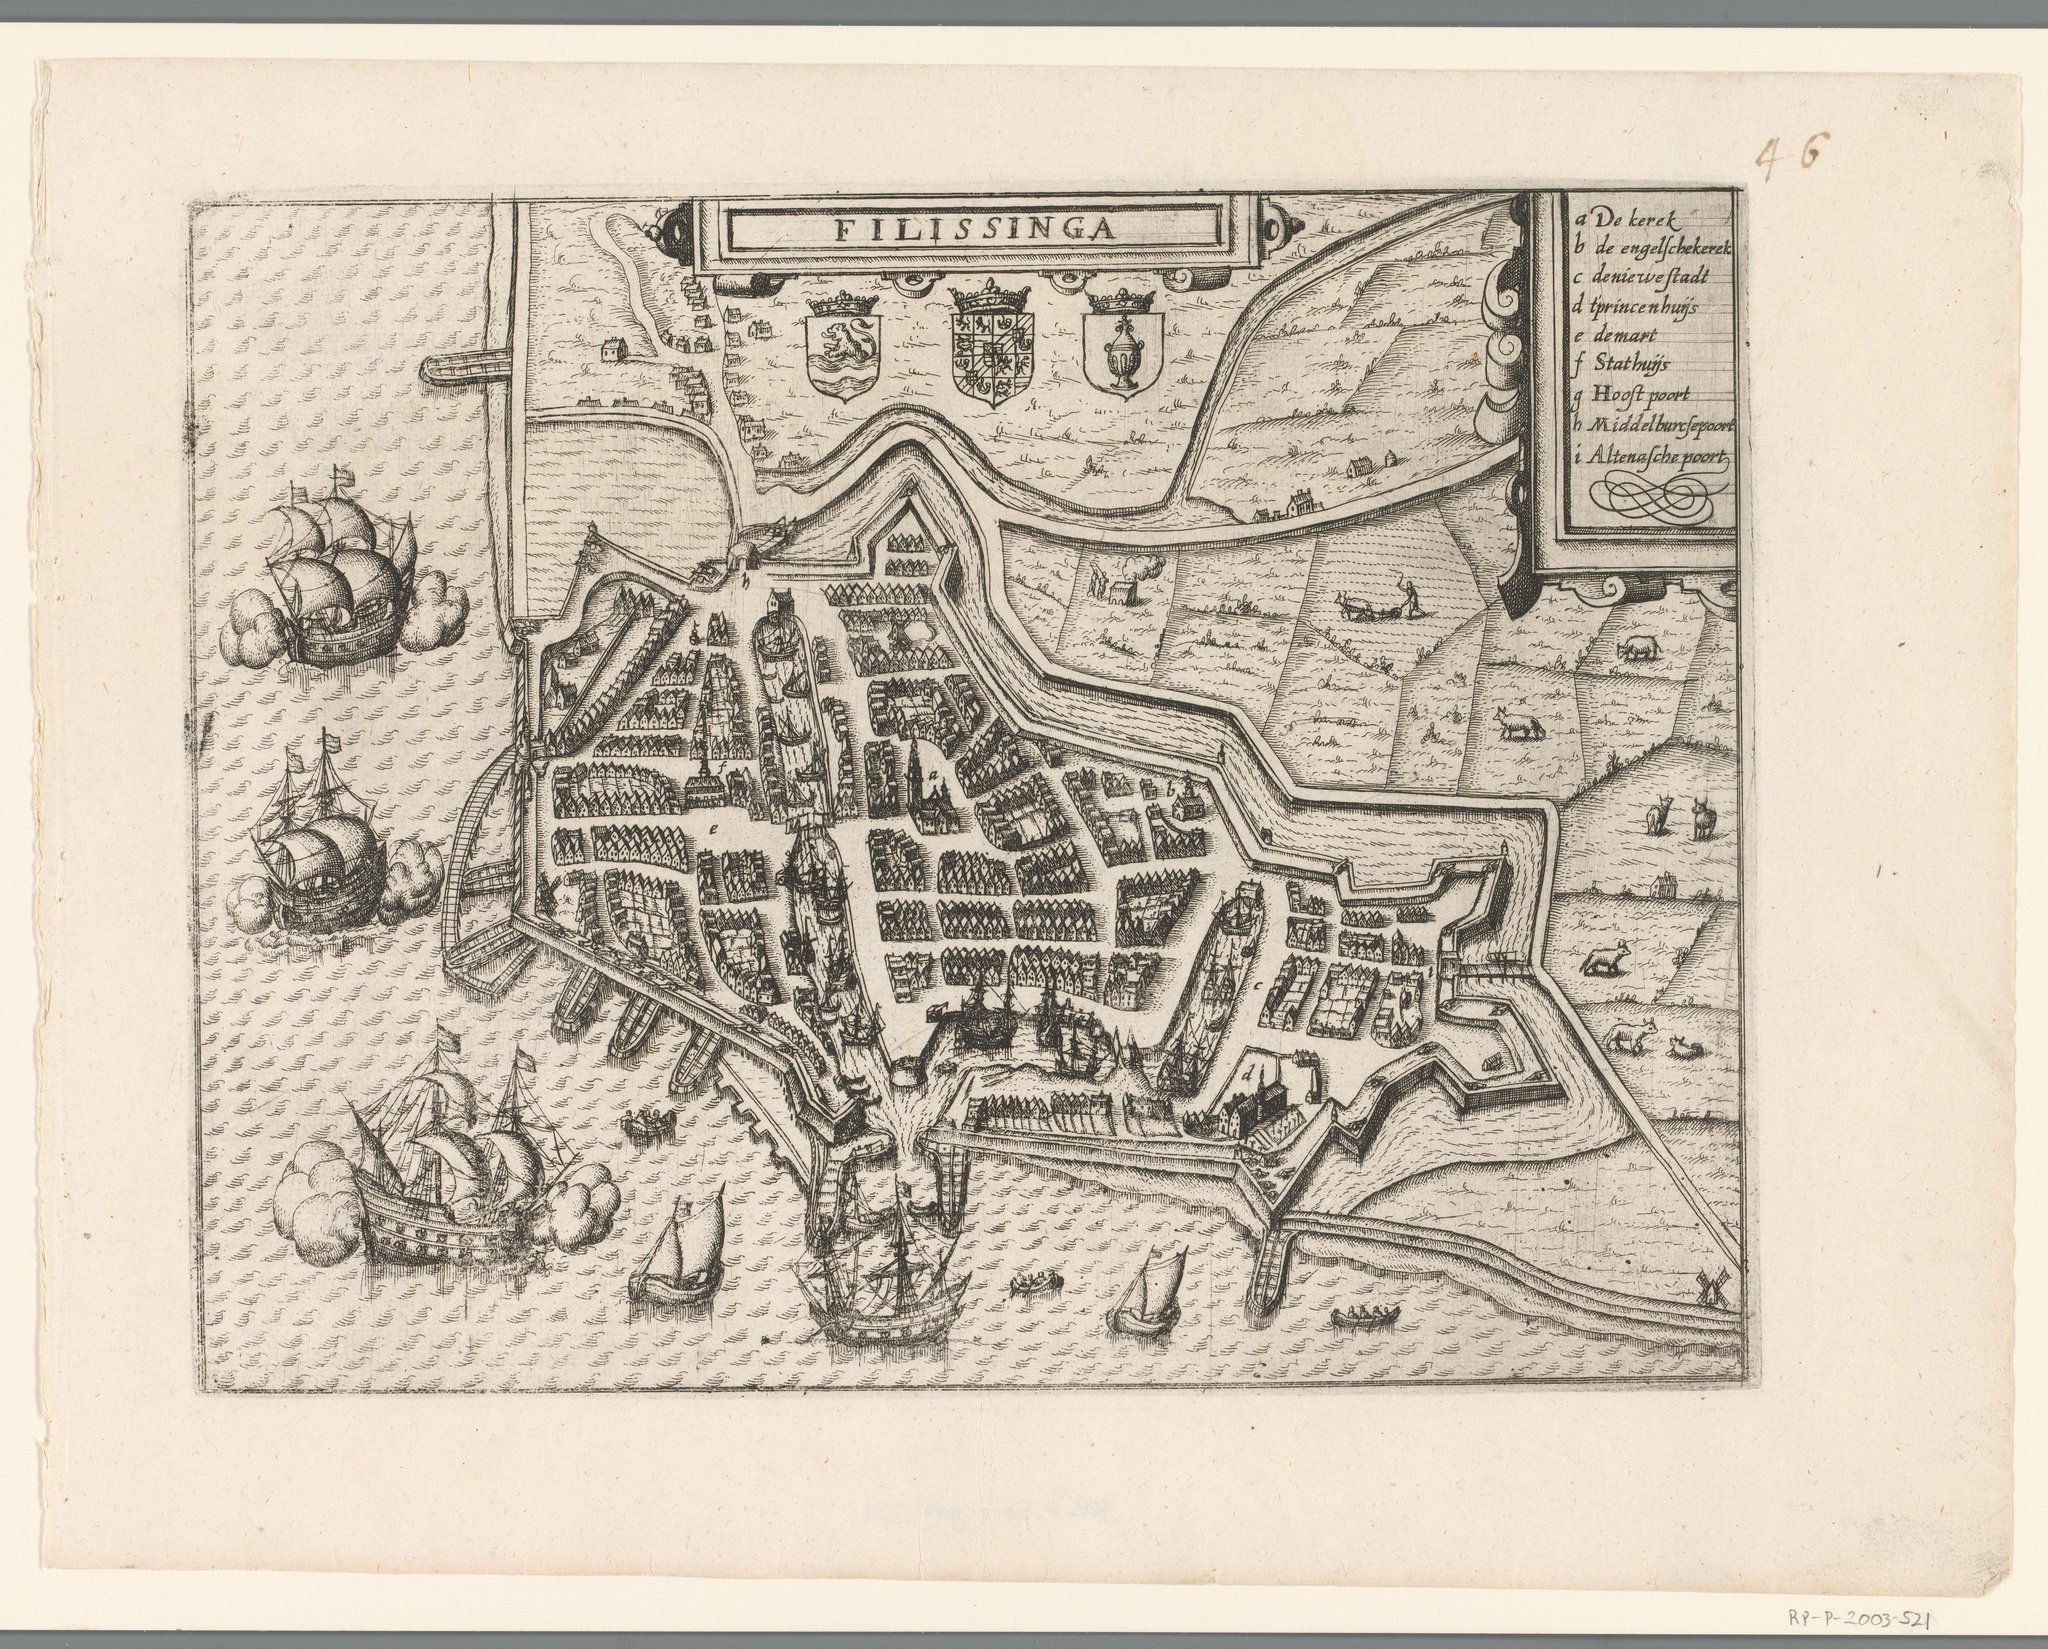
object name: print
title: Filissinga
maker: Anonymous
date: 1607-1609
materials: paper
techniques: etching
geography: northern netherlands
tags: maps of cities, flushing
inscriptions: number: ‘46’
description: Plattegrond van de stad Vlissingen. Midden boven een cartouche met de titel. Daaronder van links naar rechts het provinciewapen van Zeeland, het wapen van Oranje-Nassau en het stadswapen. Rechtsboven een cartouche met de legenda a-i. Voor de haven enkele schepen die saluutschoten lossen. Onderdeel van de verzameling kaarten genomen uit een latere editie van: Descrittione di tutti i Paesi Bassi van Lodovico Guicciardini.